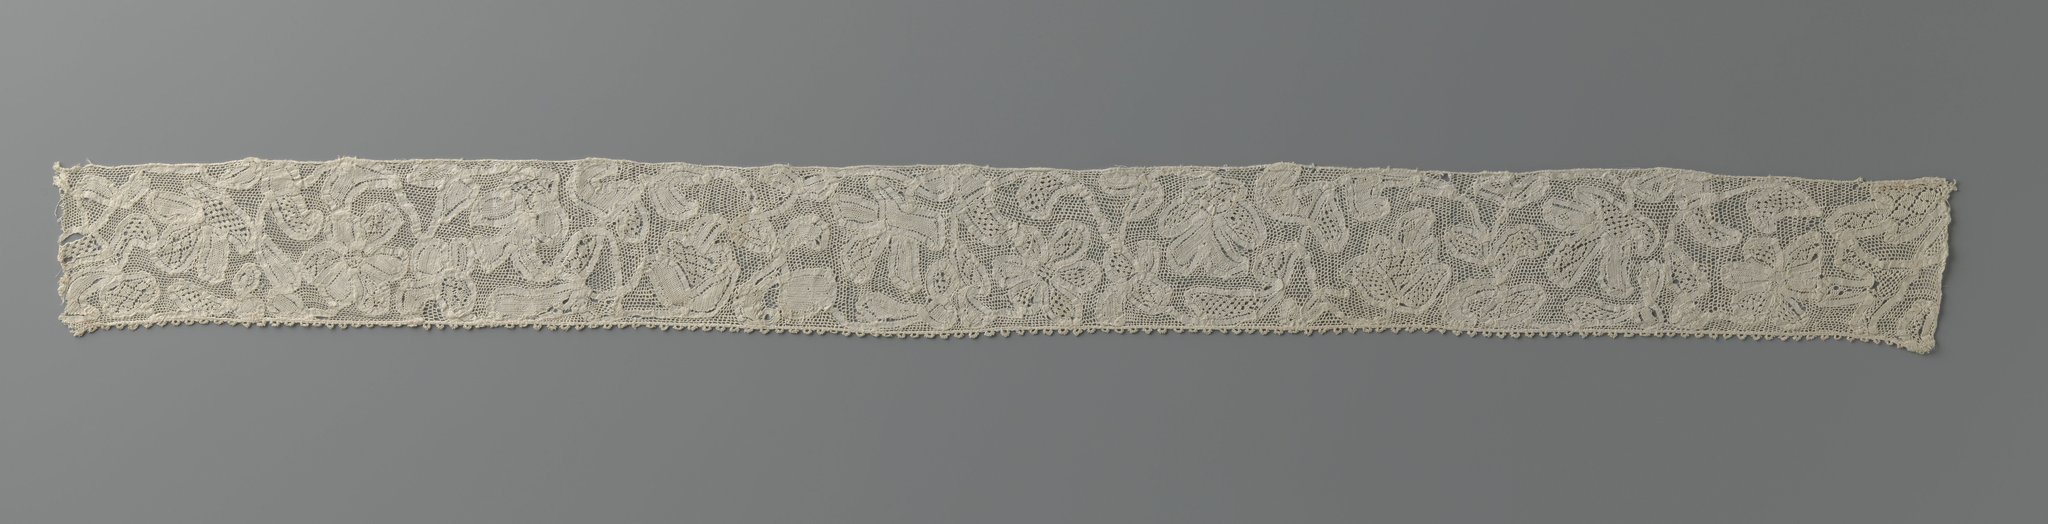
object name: strip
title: Strook gemengde kant met golvend lint waaraan verschillende bloemen en bladeren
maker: Anonymous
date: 1650-1699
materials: linen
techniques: lace, weave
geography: venice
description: Strook naturelkleurige gemengde kant: Venetiaanse lintjeskant. Langgerekt patroon met een over de volle breedte golvende rank waaraan palmetbloemen, knotsvormige bladeren, rozetbloem en vier verschillende palmetbloemen. De rank en de contouren van de motieven worden gevormd door een geweven lint. Binnen de contouren zijn verschillende (sier)gronden gemaakt met festonsteken. De motieven zijn met elkaar verbonden door een vierkante maasgrond (naaldkant). De bovenzijde is recht afgewerkt. De onderzijde is afgewerkt met een rechte picotrand met boogjes.